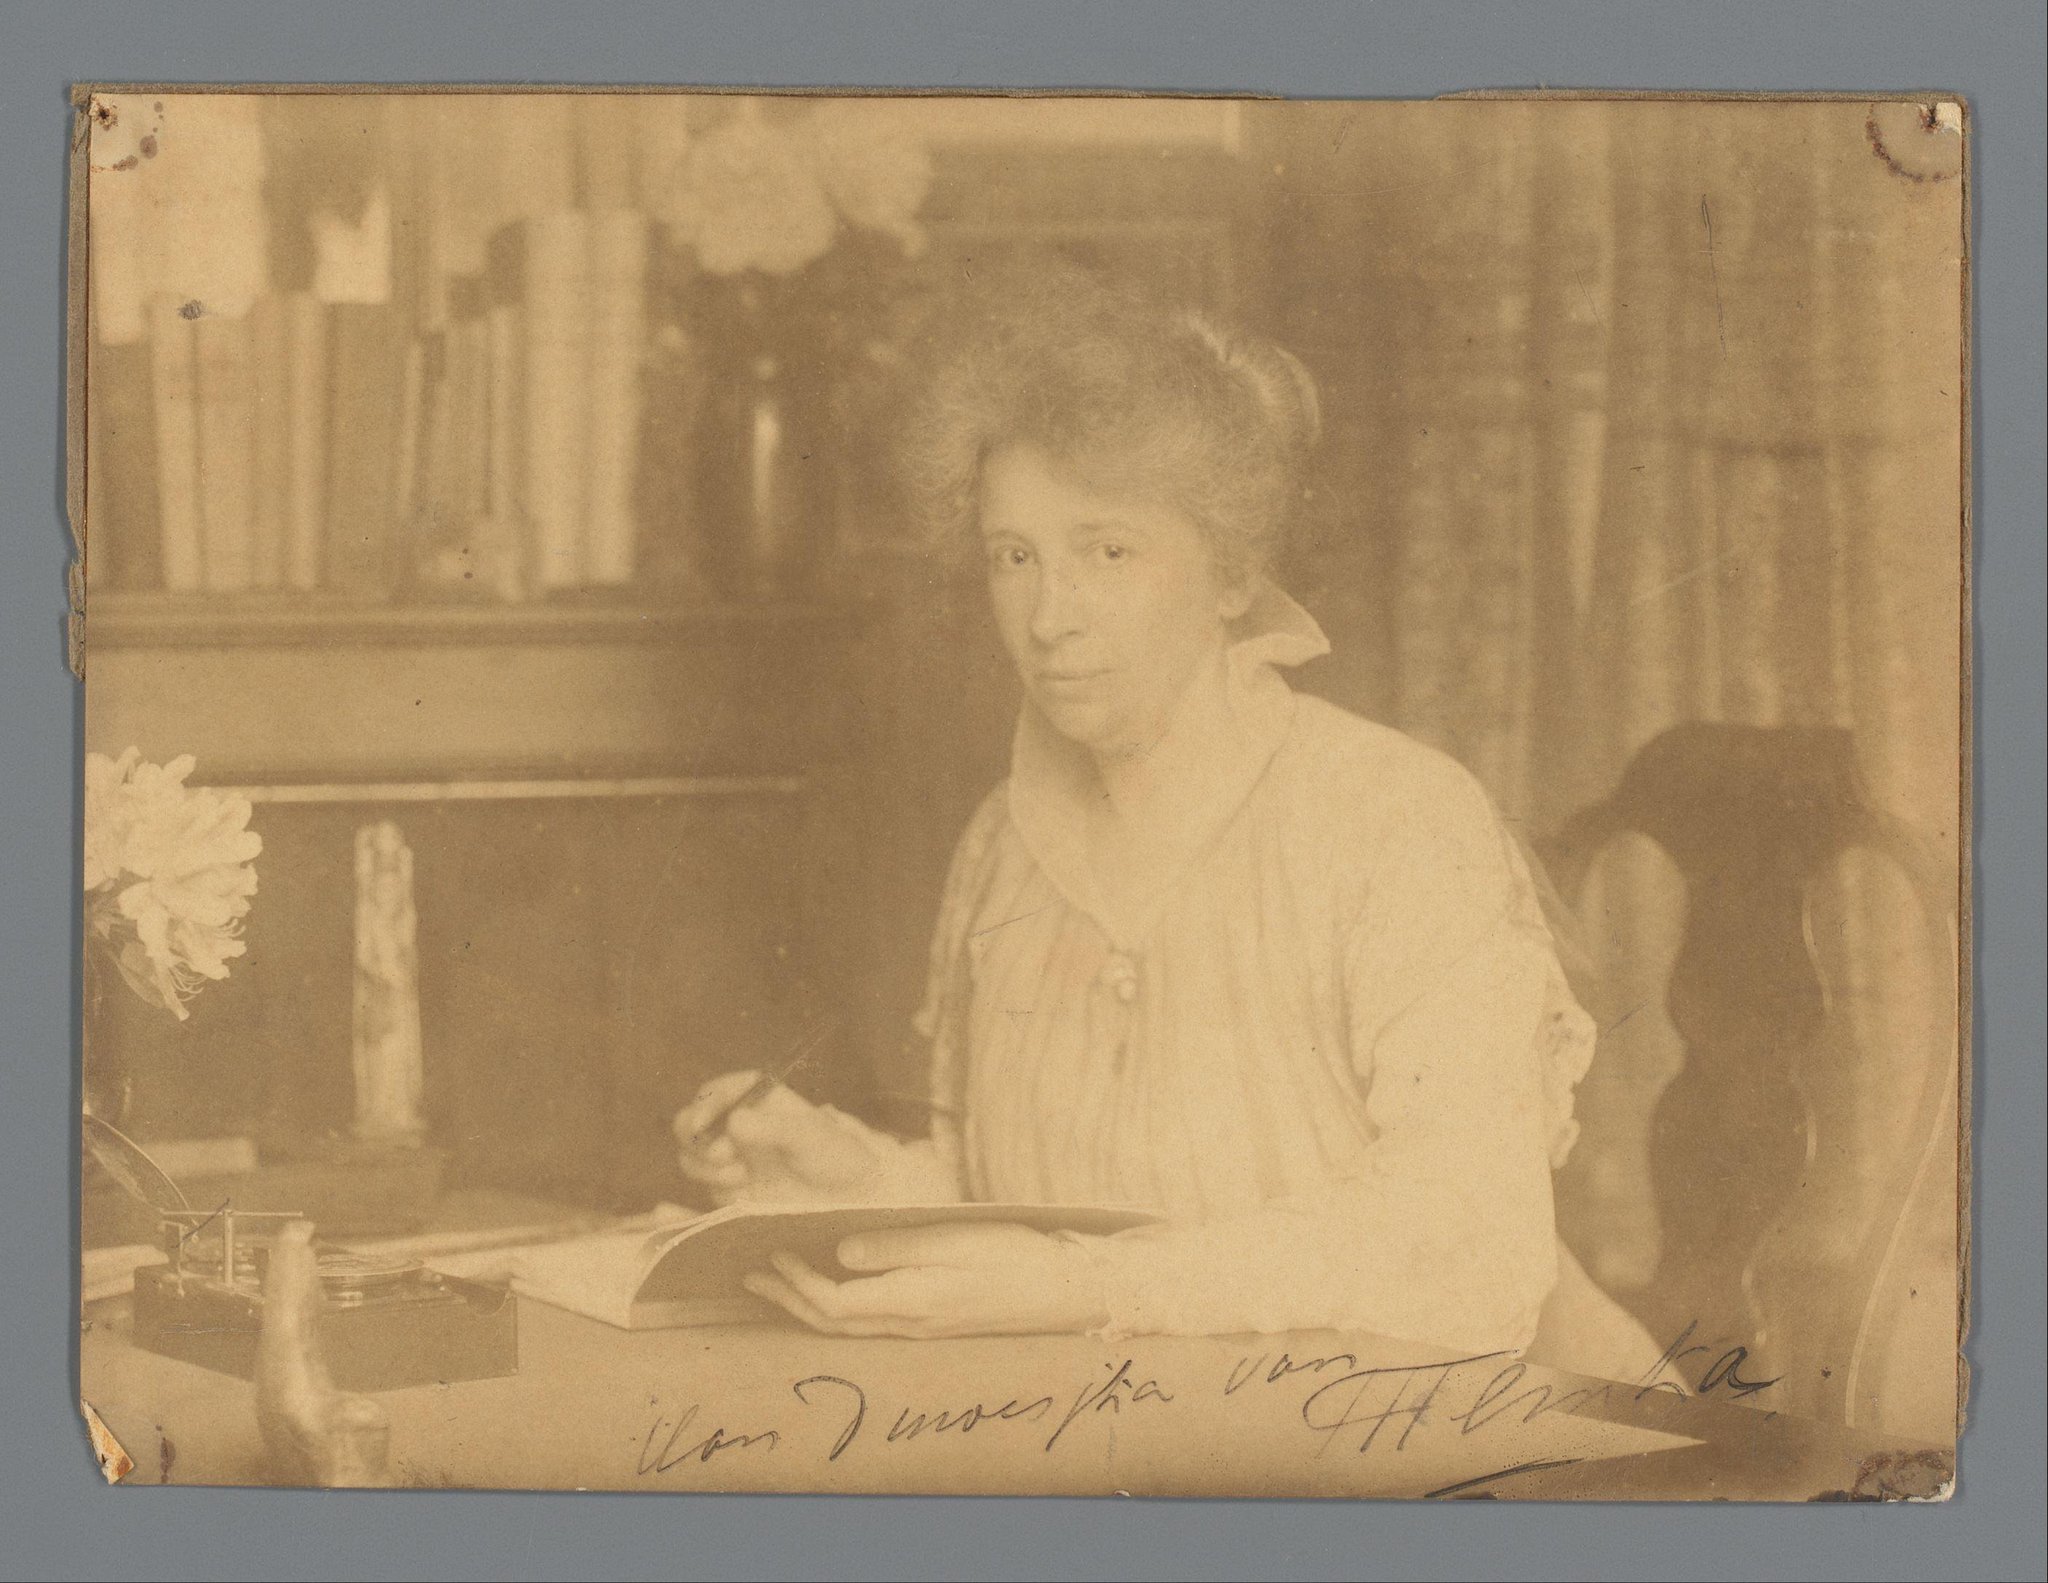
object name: photograph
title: Portret van de schrijfster Maria van Zeggelen aan schrijftafel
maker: Anonymous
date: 1910-1920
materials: cardboard, paper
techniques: albumen print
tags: maria christina van zeggelen, historical persons, author, poet writing, netherlands, dutch east indies, the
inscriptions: inscription: ‘Aan d moesjka van Themka [?]’